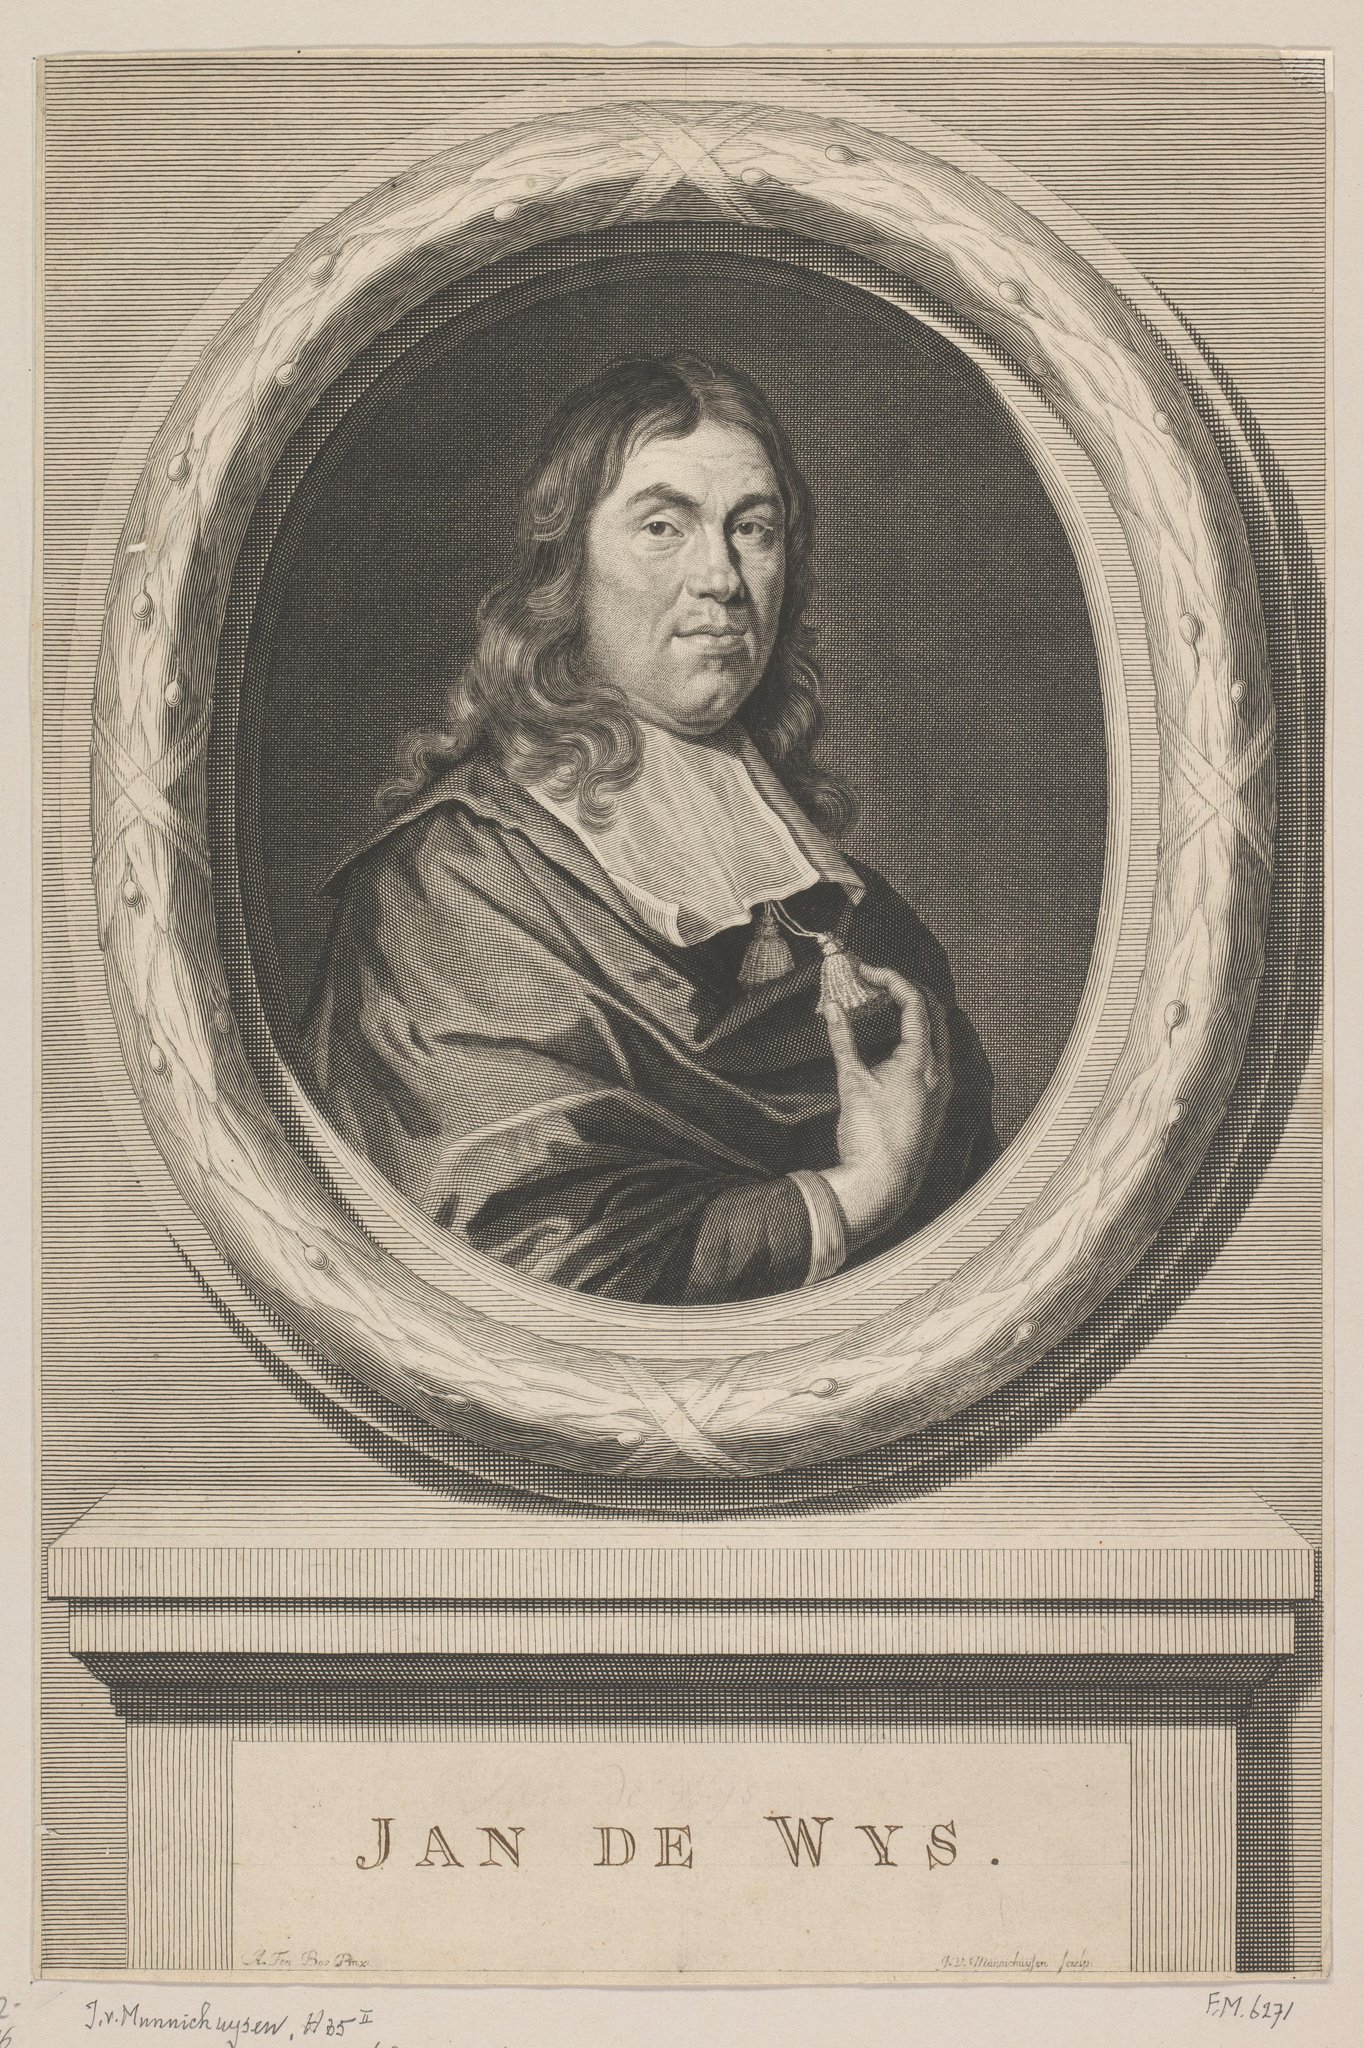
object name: print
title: Portret van Jan de Wys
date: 1670-1720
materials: paper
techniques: engraving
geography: amsterdam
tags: historical persons, merchant, salesman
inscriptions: inscription: ‘Jan de Wys’